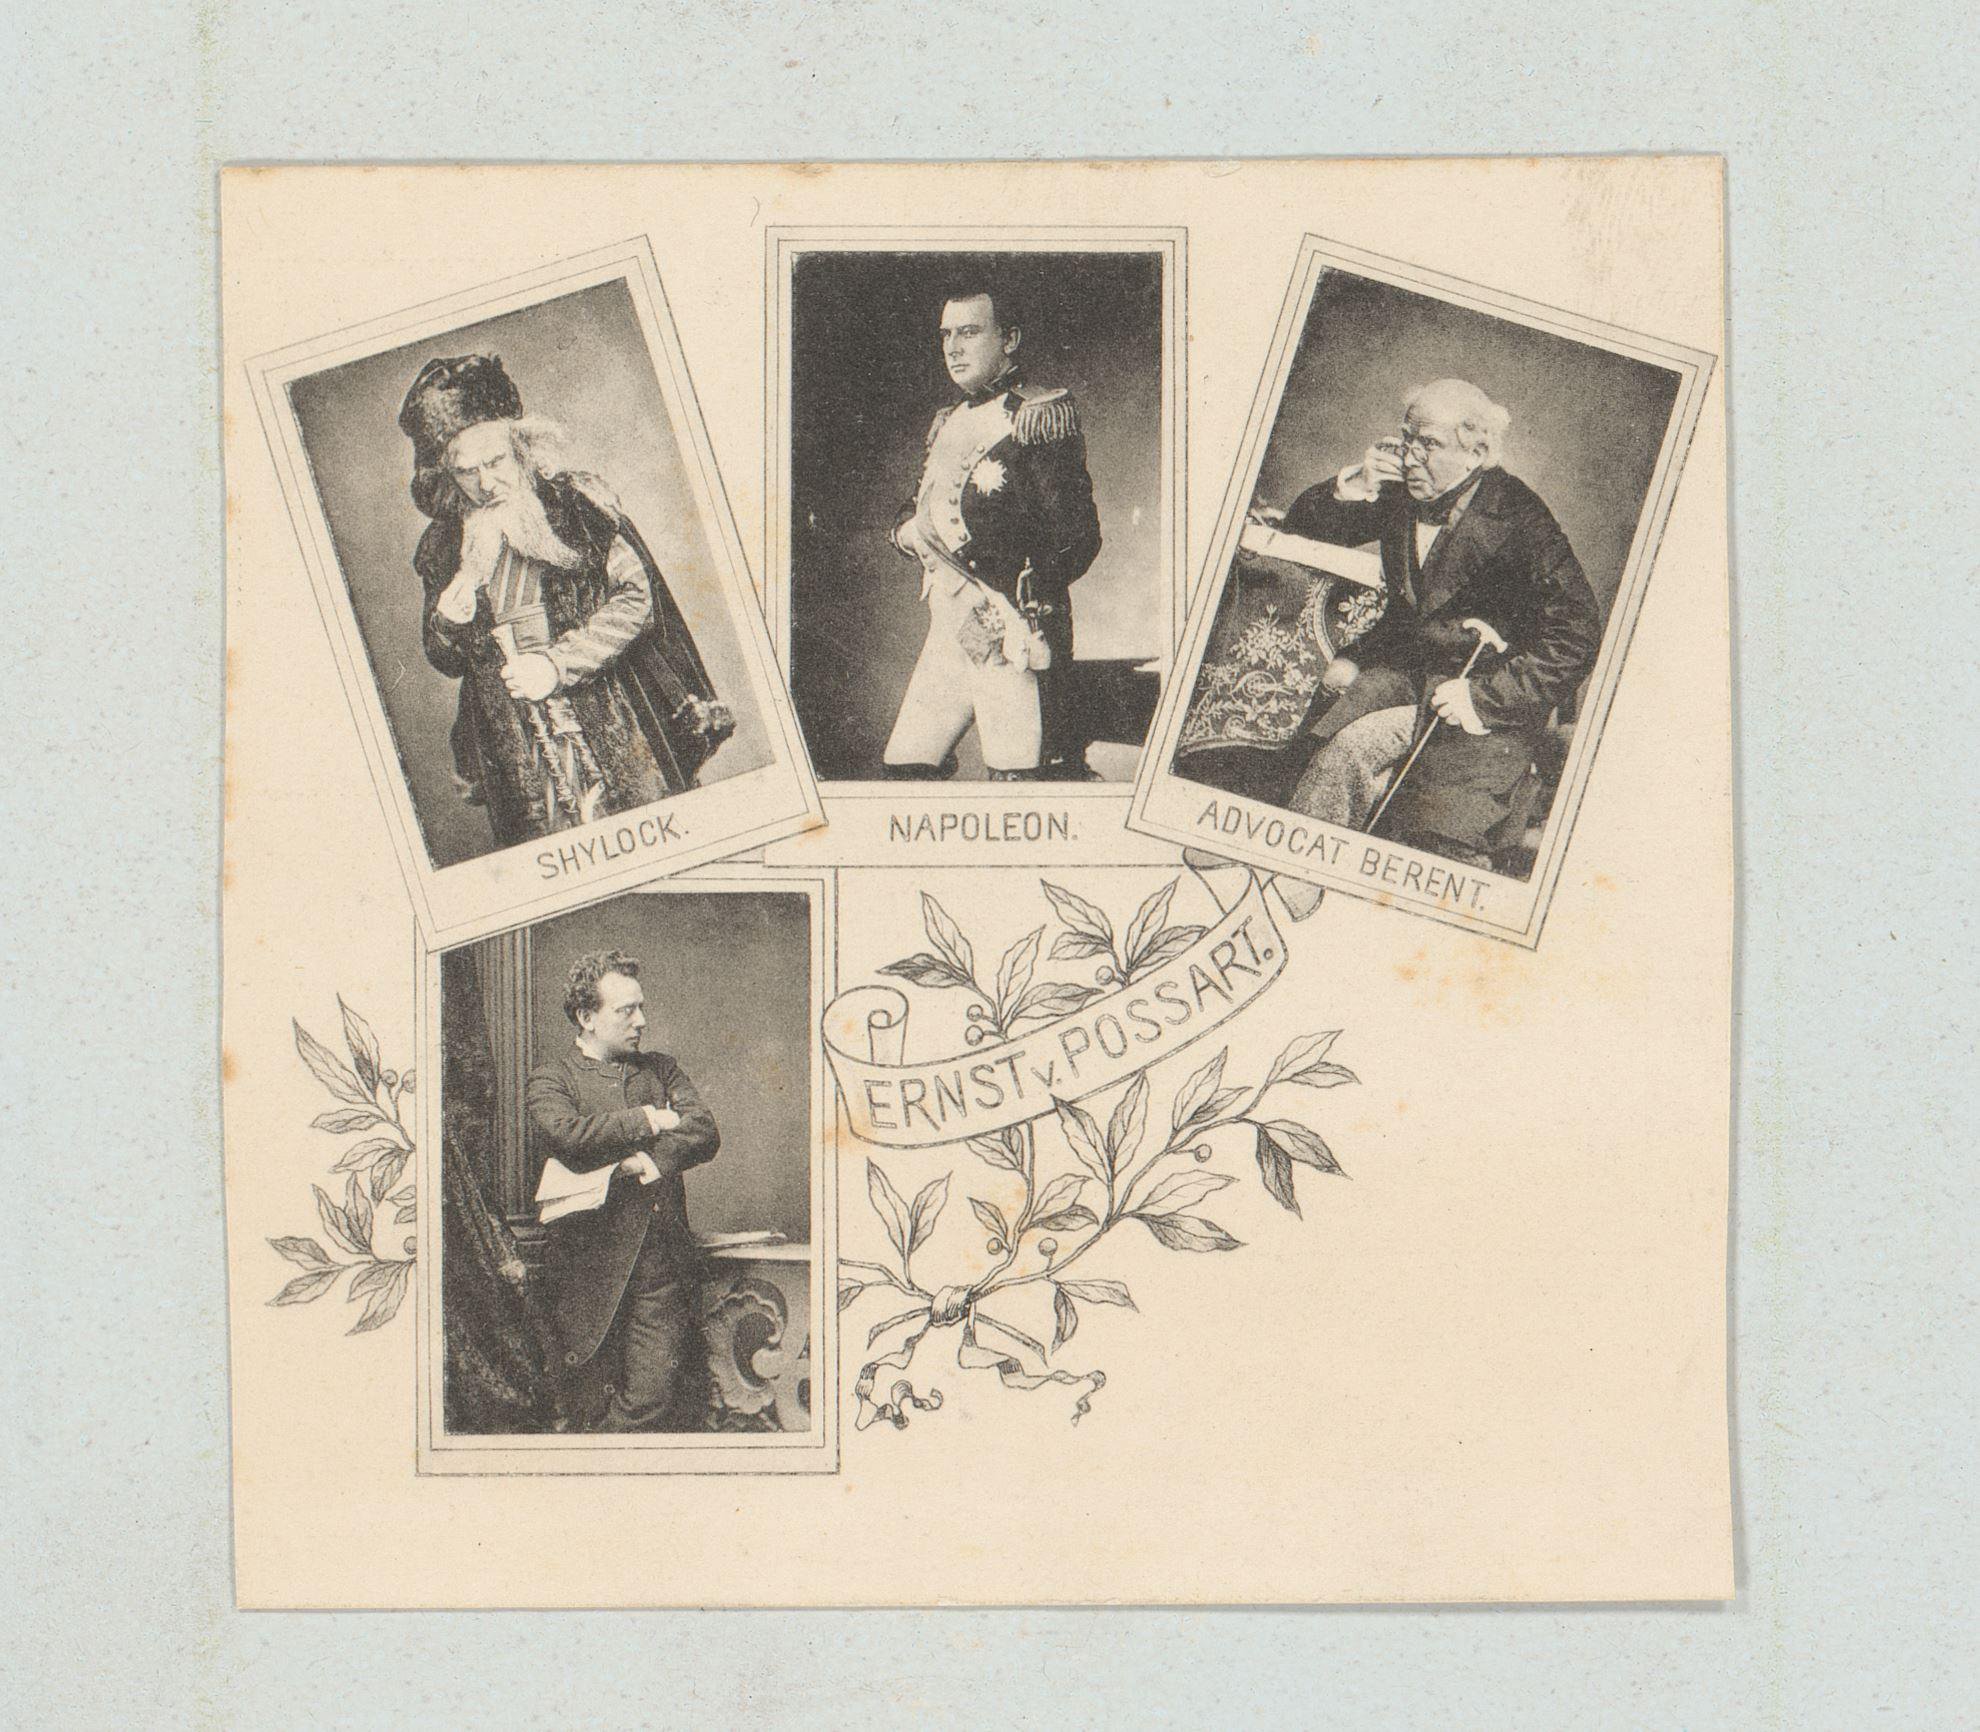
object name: photomechanical print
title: Vier portretten van acteur Ernst von Possart in de rollen Shylock, Napoleon en Advocat Berent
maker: Anonymous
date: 1890-1930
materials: cardboard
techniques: photograph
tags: historical persons, portrait of actor, actress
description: Deze prent maakt deel uit van een album.